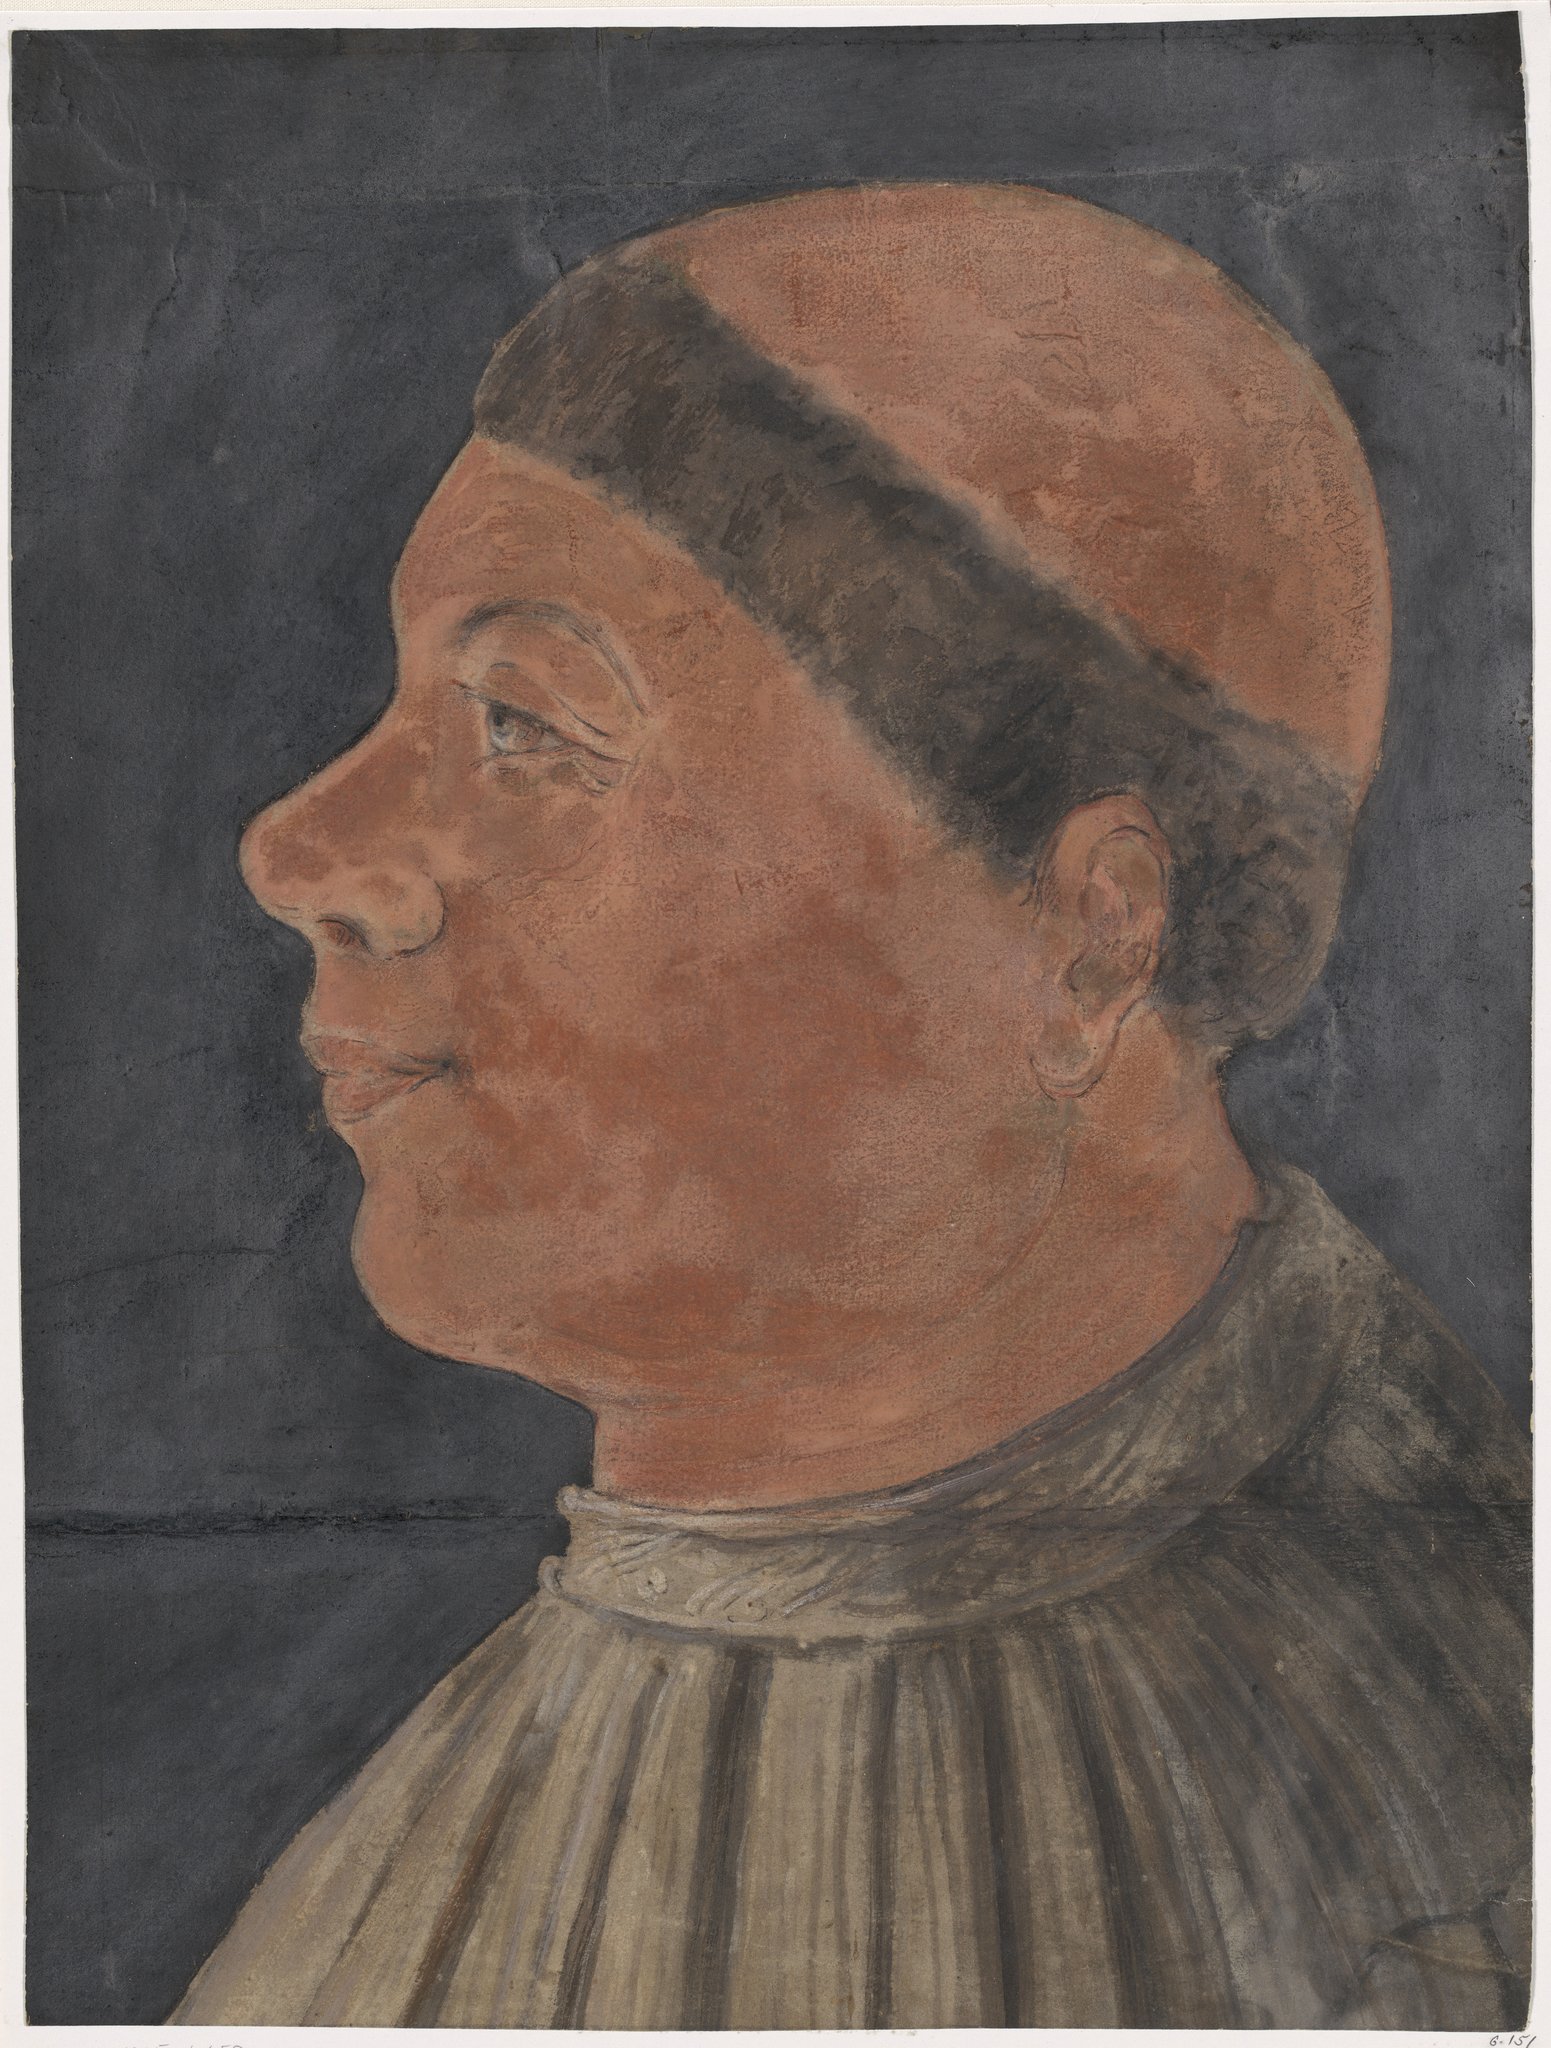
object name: drawing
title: Profile Portrait of Bishop Antonius Campanus of Agram (Zagreb)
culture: french or italian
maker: french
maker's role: artist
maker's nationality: french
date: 1467-1533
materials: copper, ink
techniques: pen, wash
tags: men,profiles,bishops